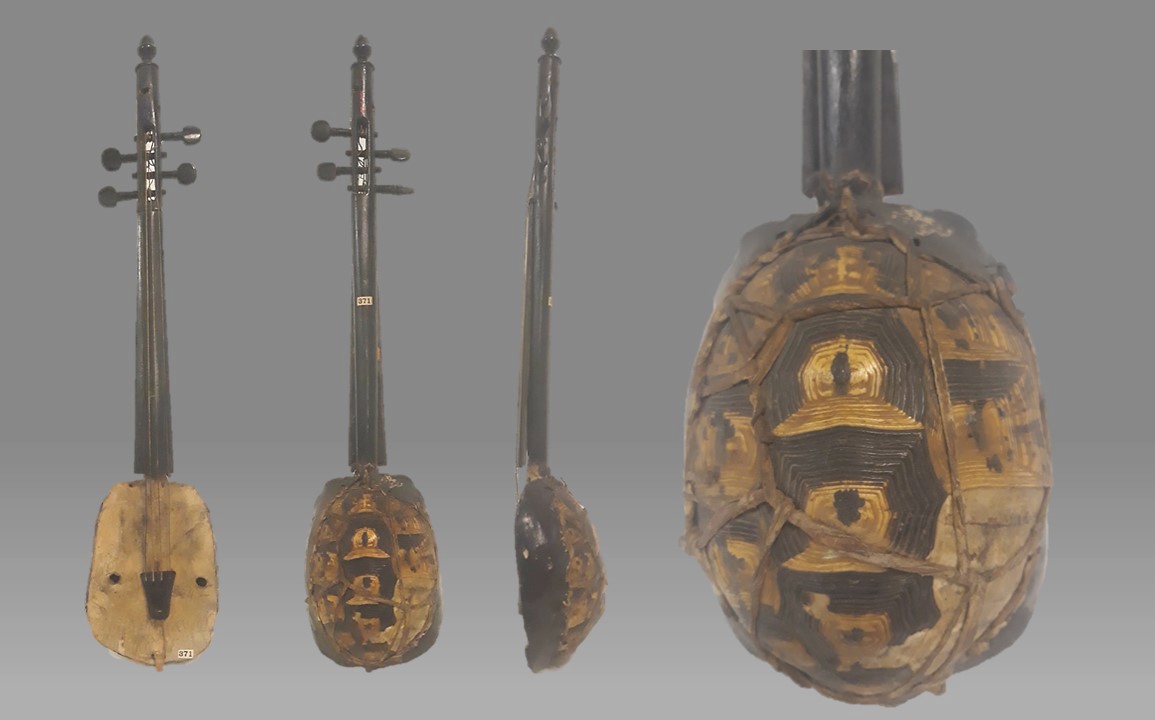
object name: stringed instrument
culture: arabian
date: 1867-1900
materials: shell, wood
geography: arabia